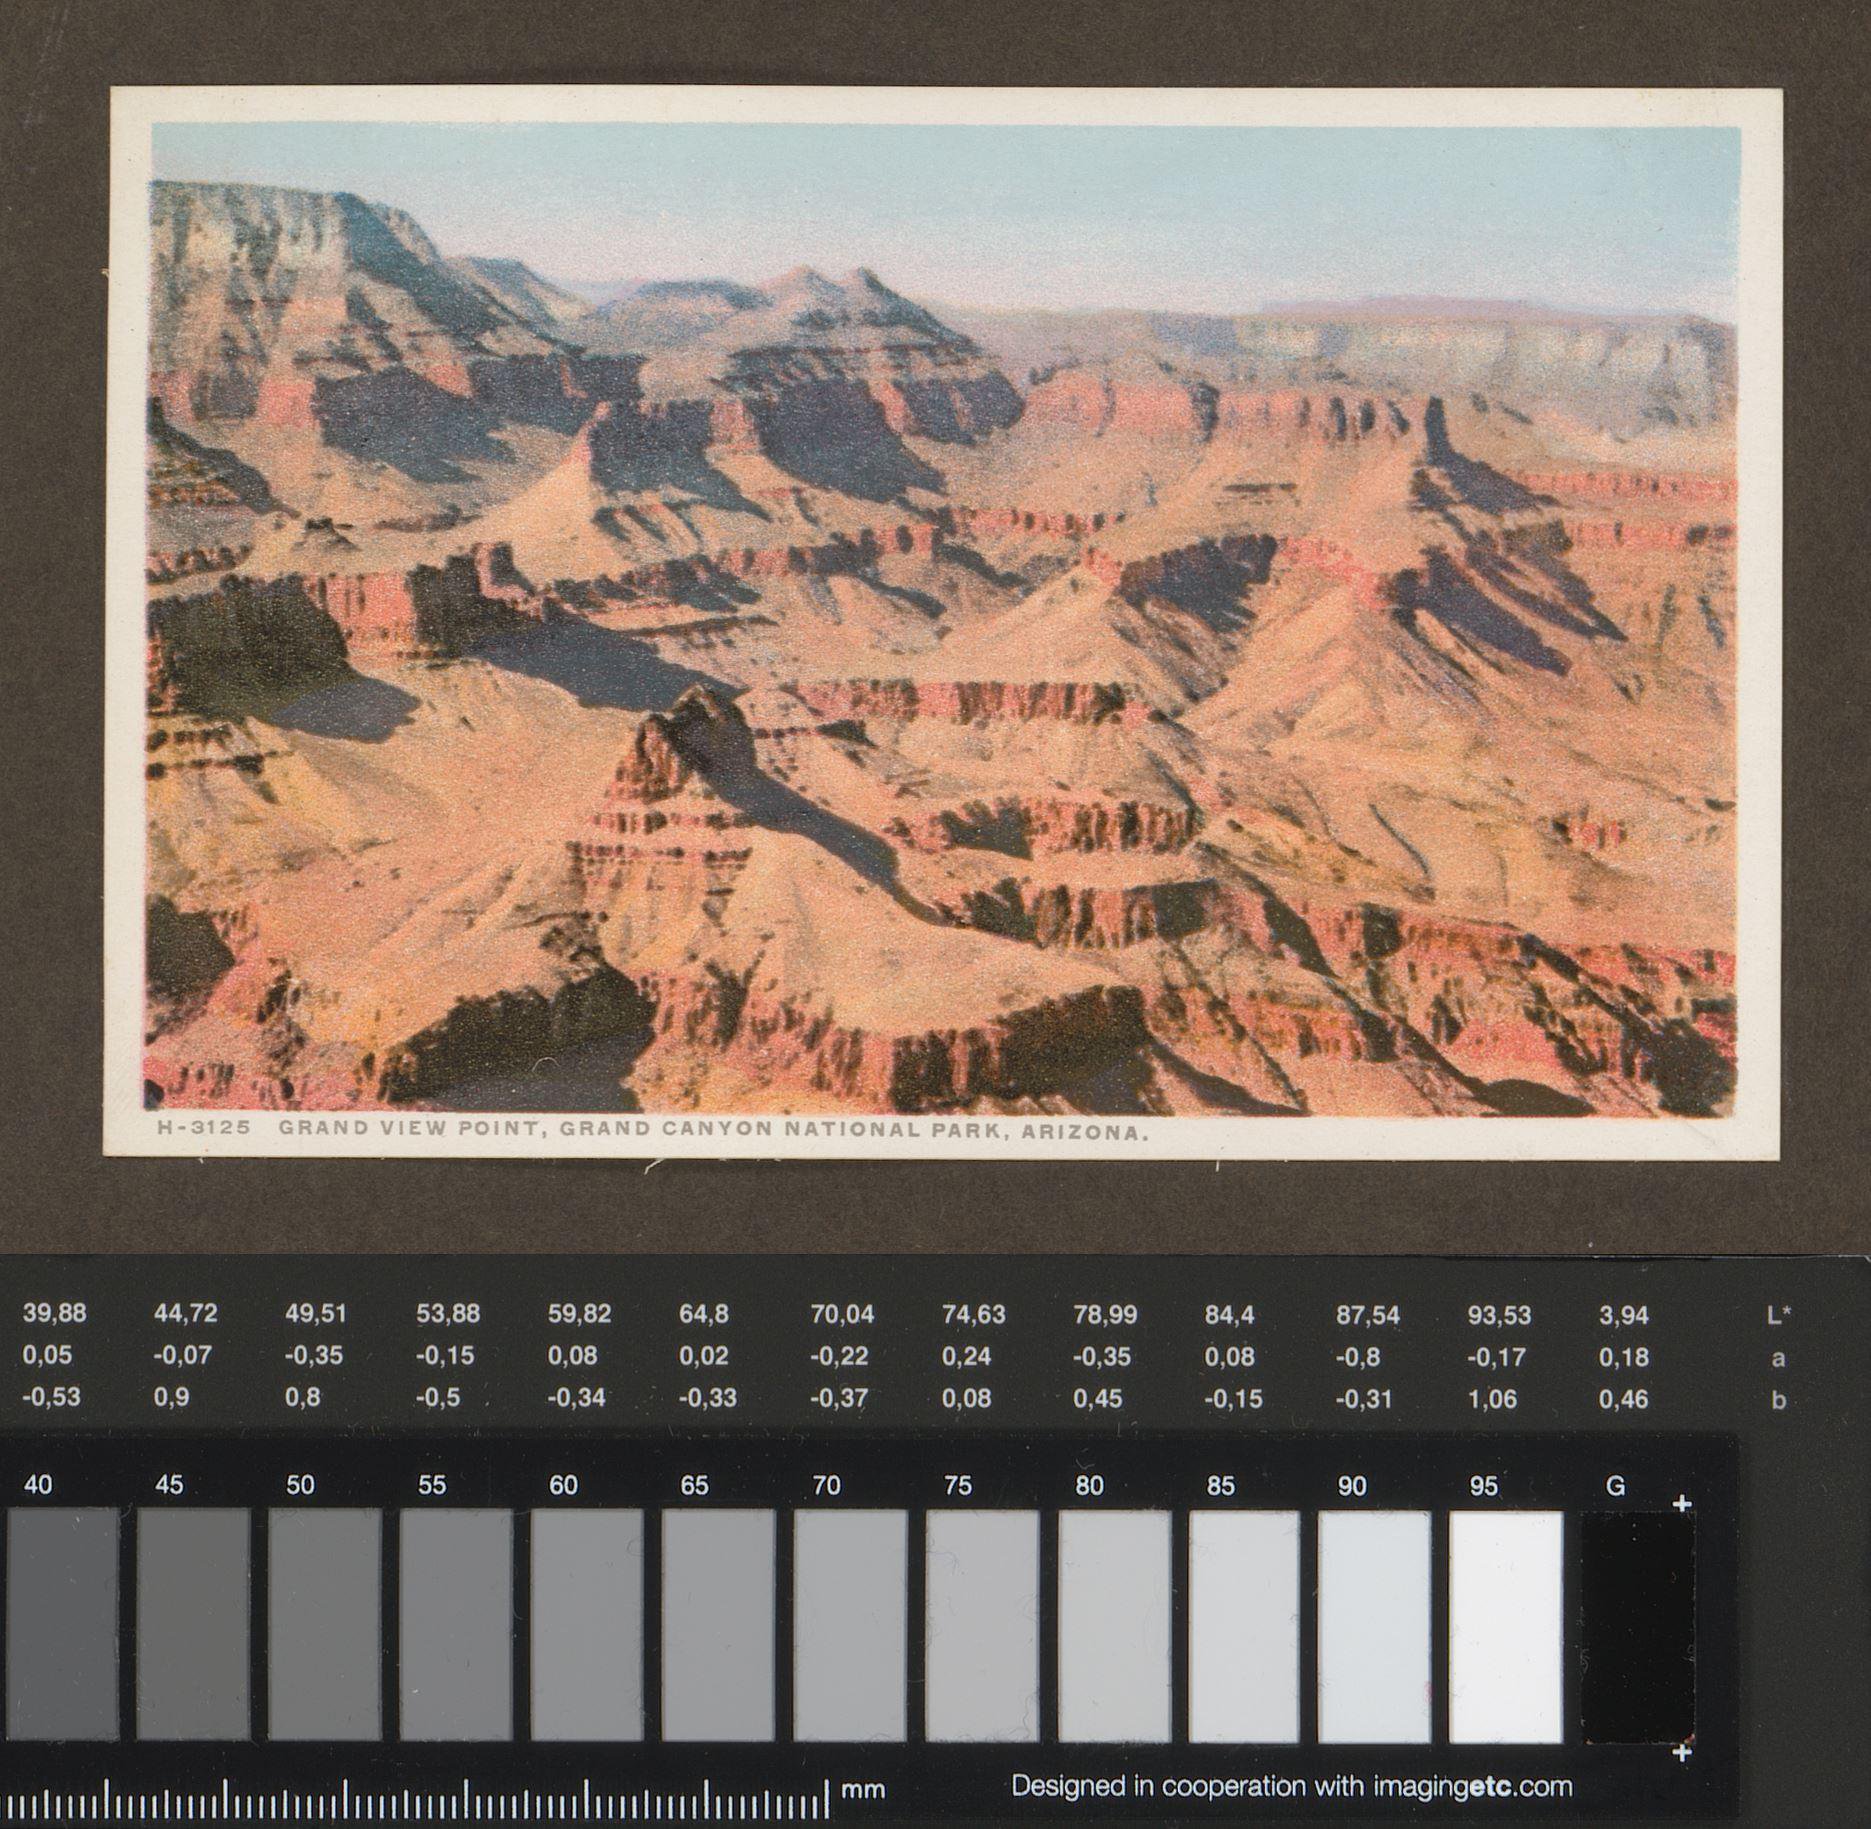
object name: photomechanical print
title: Grand view point, Grand Canyon National Park, Arizona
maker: Anonymous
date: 1928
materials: paper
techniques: chromolithography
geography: grand canyon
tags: shop, store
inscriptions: number: ‘H-3125’, annotation: ‘Grand Canyon’